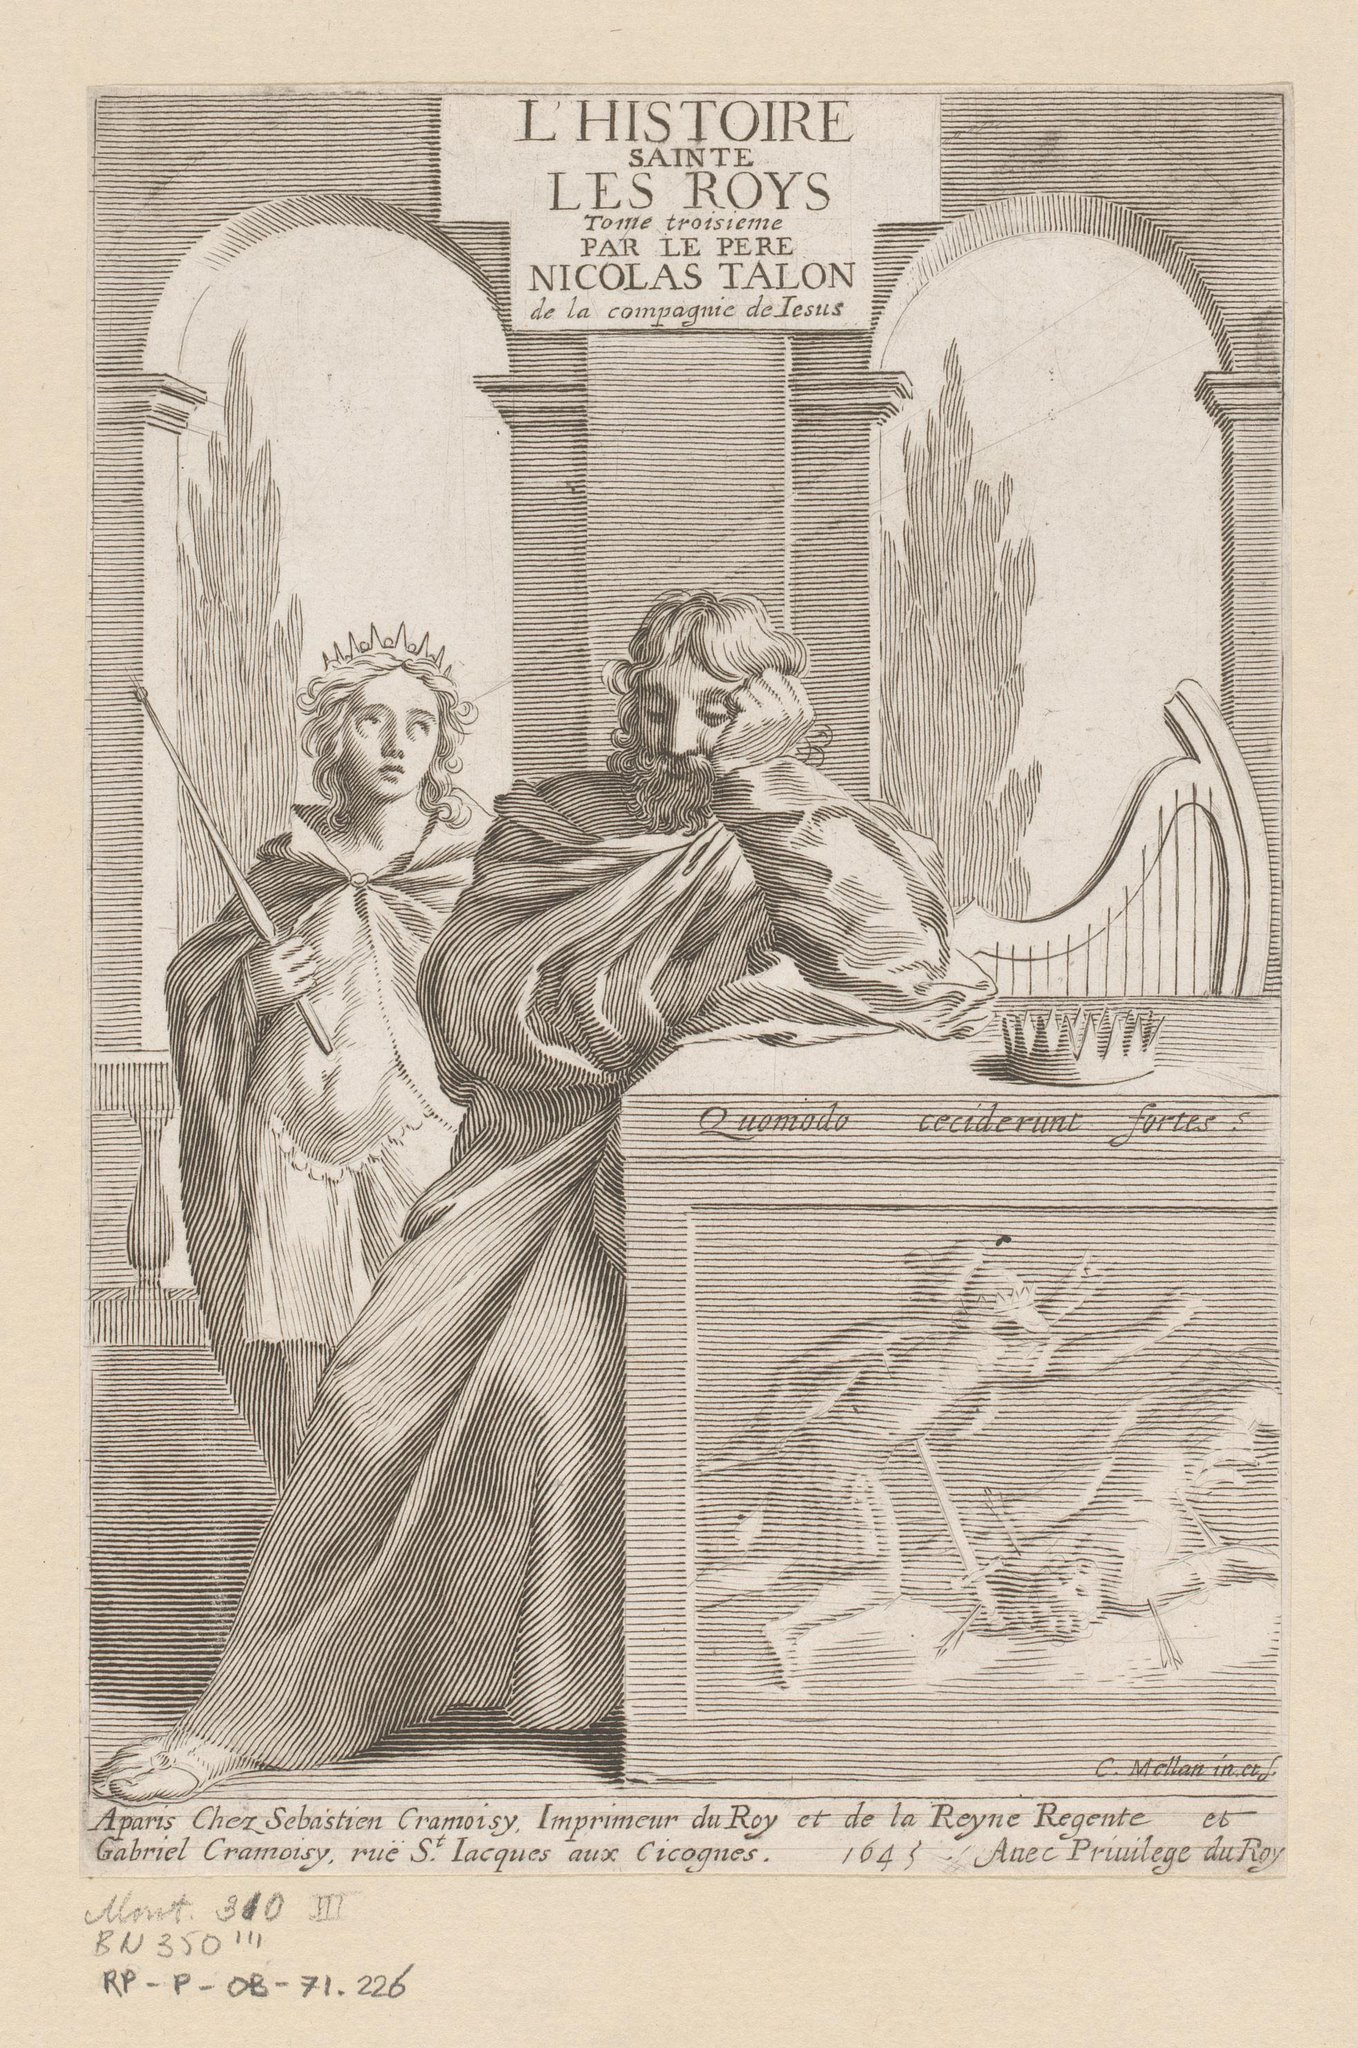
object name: print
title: L'Histoire Sainte Roys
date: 1645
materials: paper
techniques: engraving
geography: france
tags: story of david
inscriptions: collector's mark: Lugt 240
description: Titelpagina voor: Talon, Nicolas. L'Histoire sainte. Parijs: Gabriel Cramoisy, 1645, dl. 3. Deze staat is eveneens gebruikt voor de editie uit 1654.